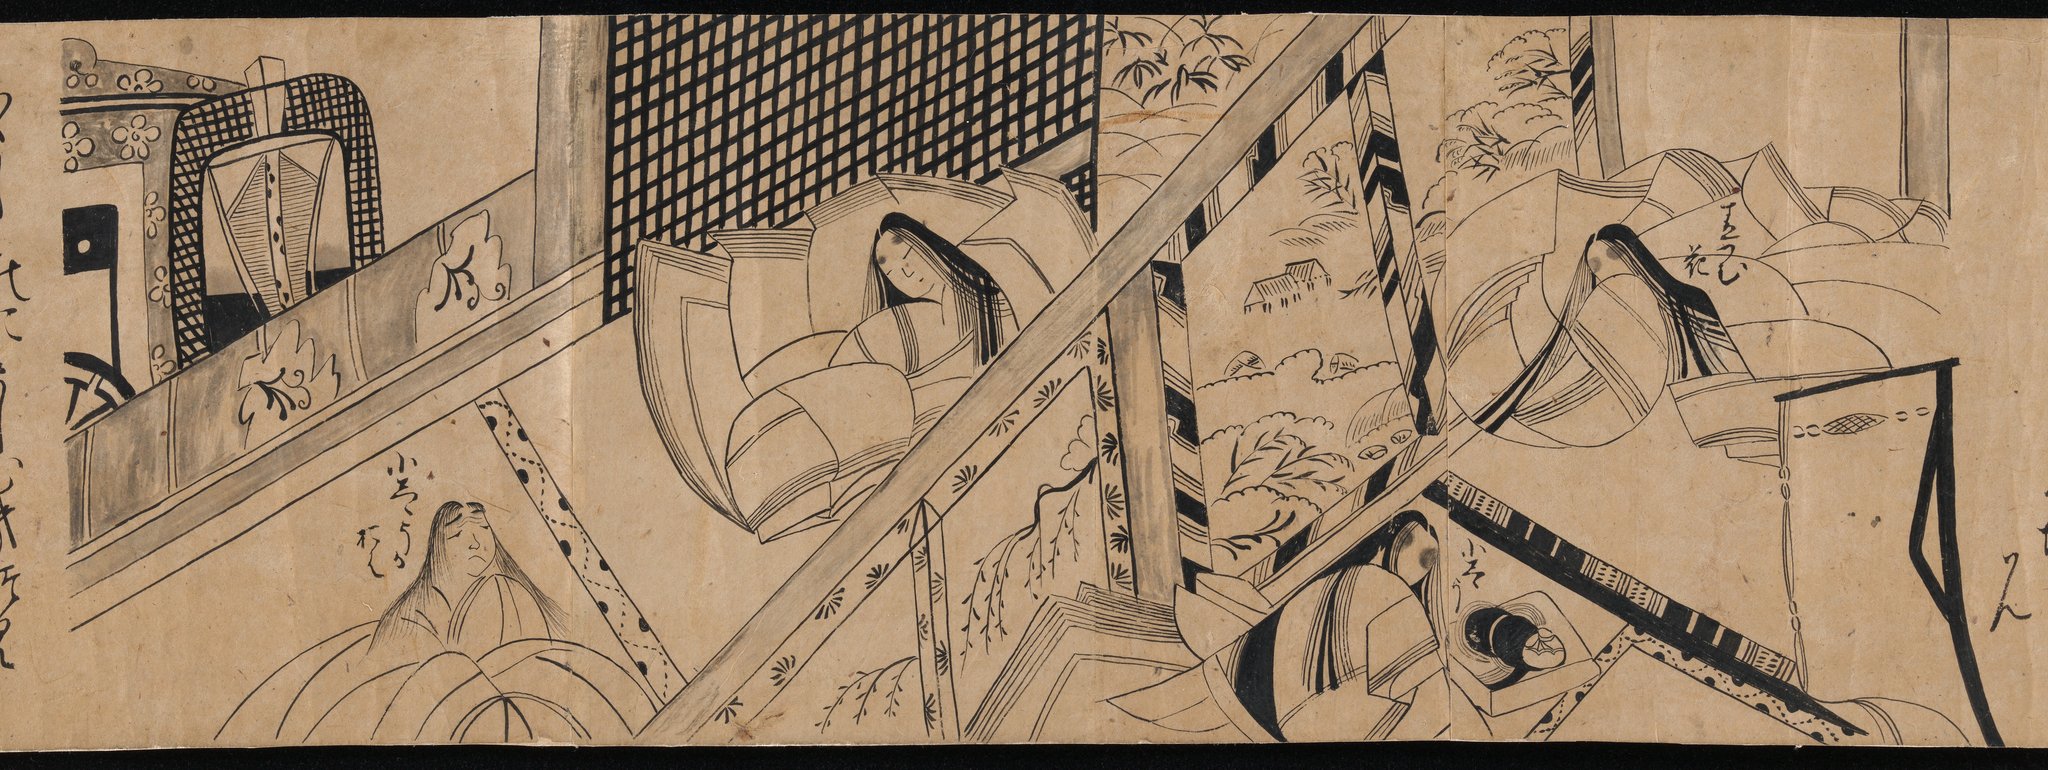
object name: handscroll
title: "Akashi", "Channel Buoys" ("Miotsukushi"), "The Wormwood Patch" ("Yomogiu"), "Gatehouse" ("Sekiya"), and "Picture Contest" ("E-awase") chapters from the Tale of Genji (Genji monogatari)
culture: japanese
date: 1392-1573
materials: ink, paper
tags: men,women